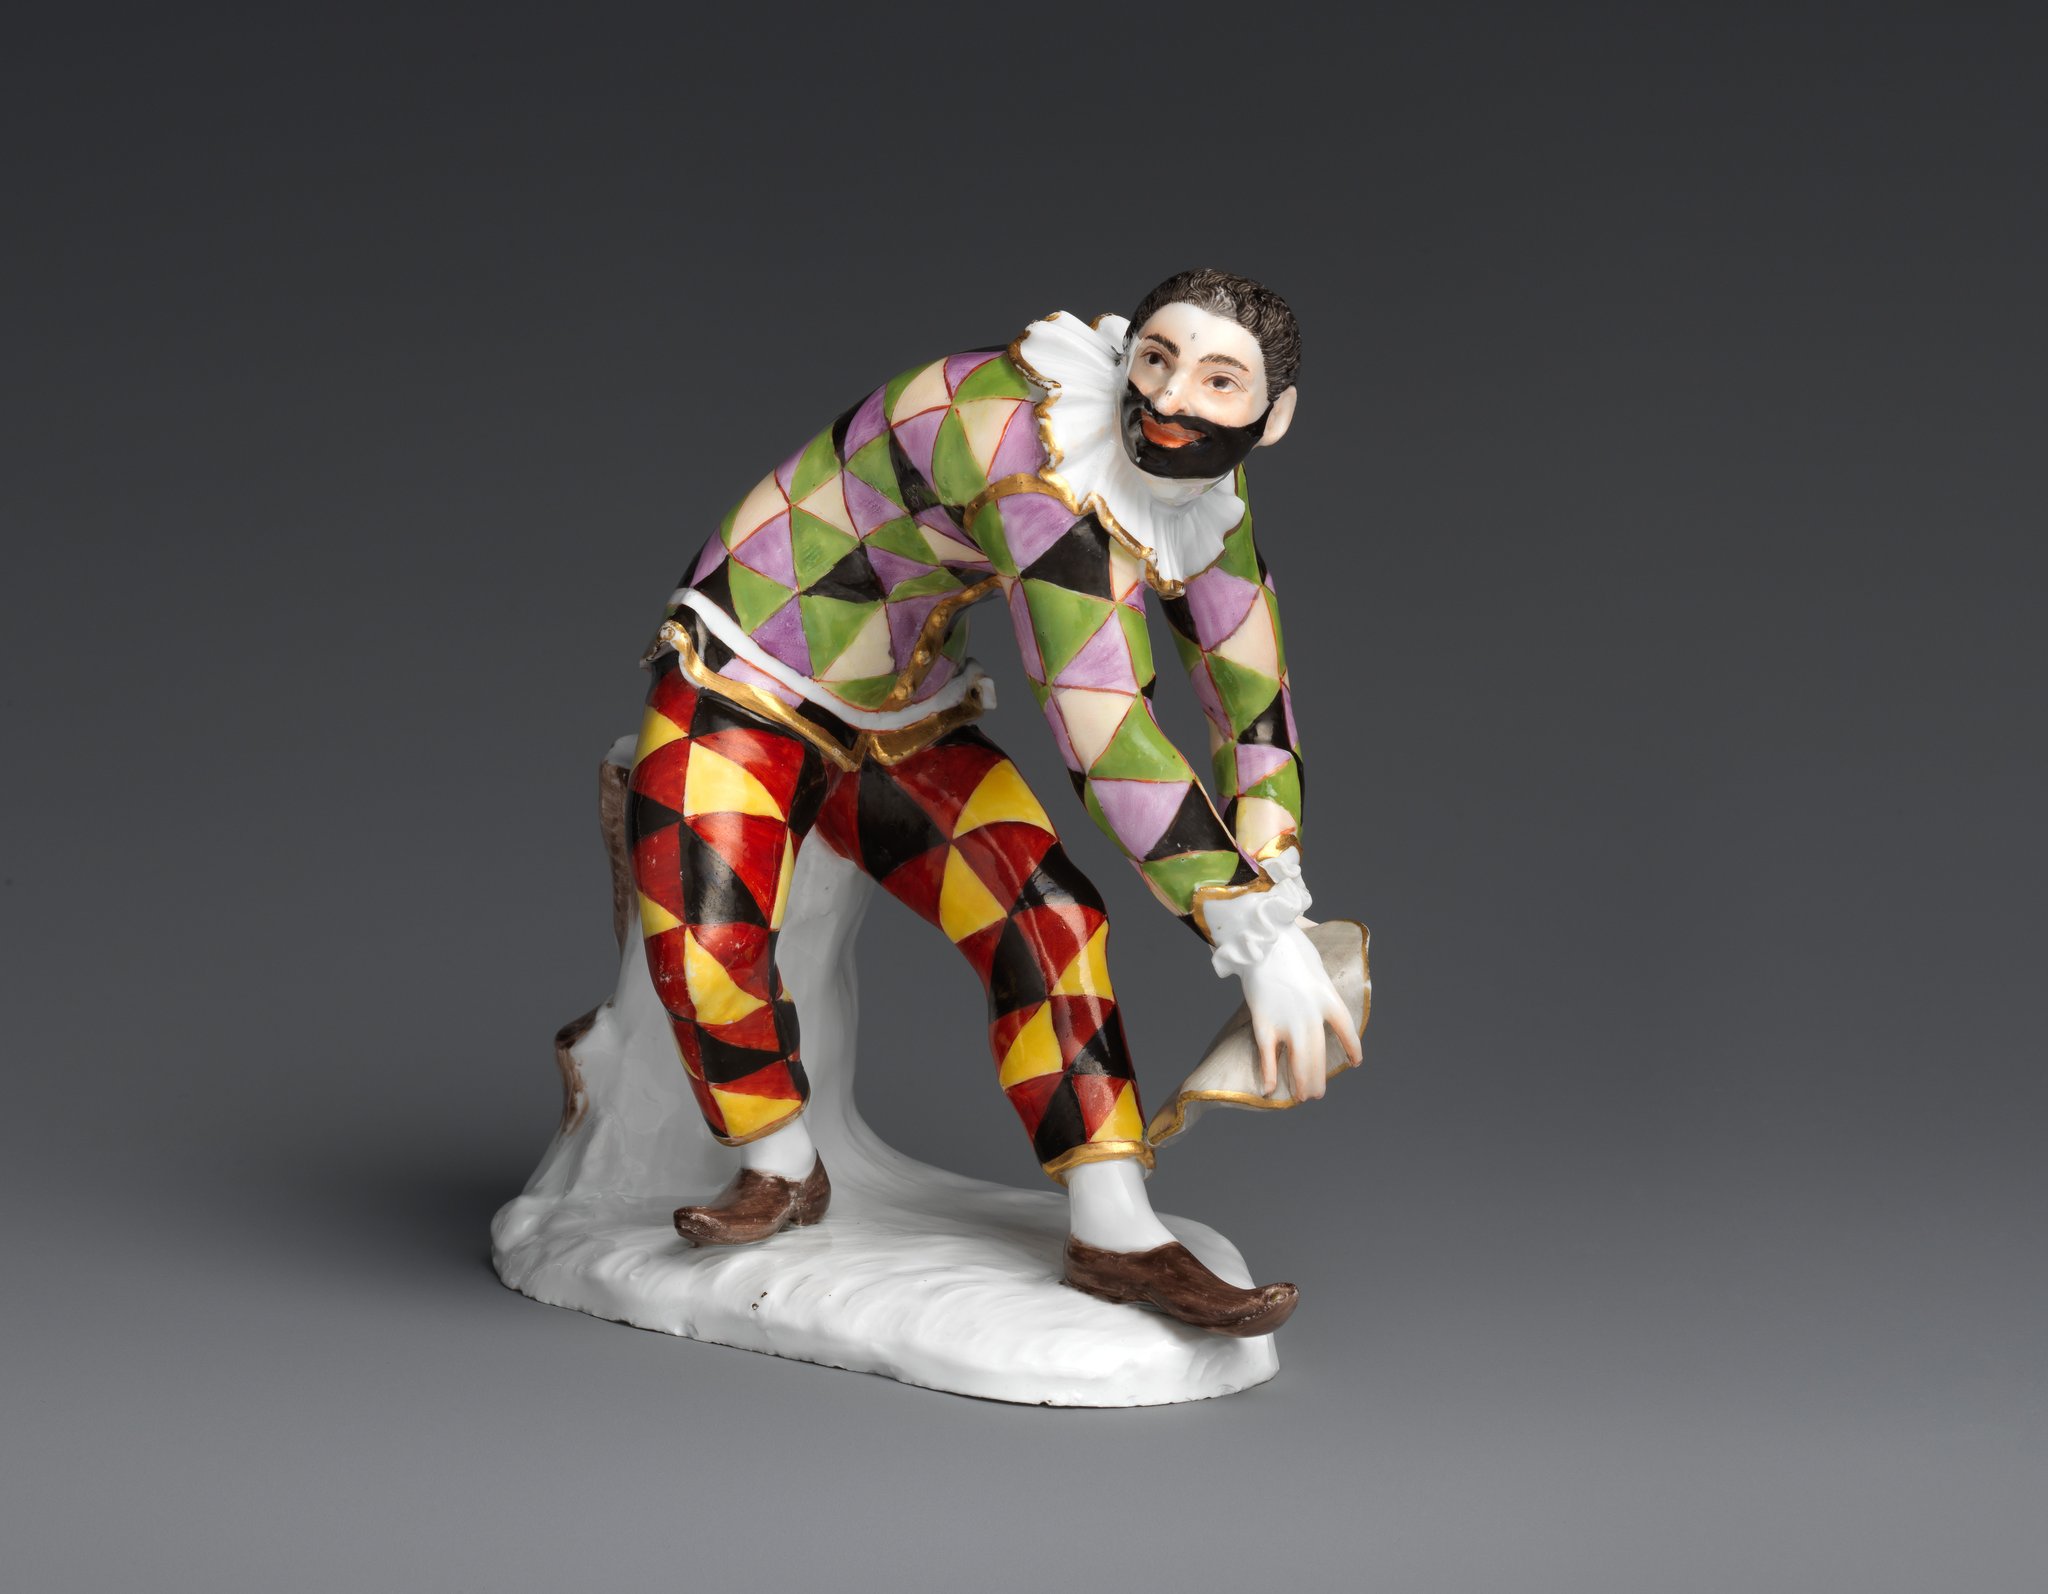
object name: figure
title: Bowing Harlequin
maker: meissen manufactory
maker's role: manufactory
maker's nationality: german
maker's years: 1710-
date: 1740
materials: hard paste porcelain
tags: men